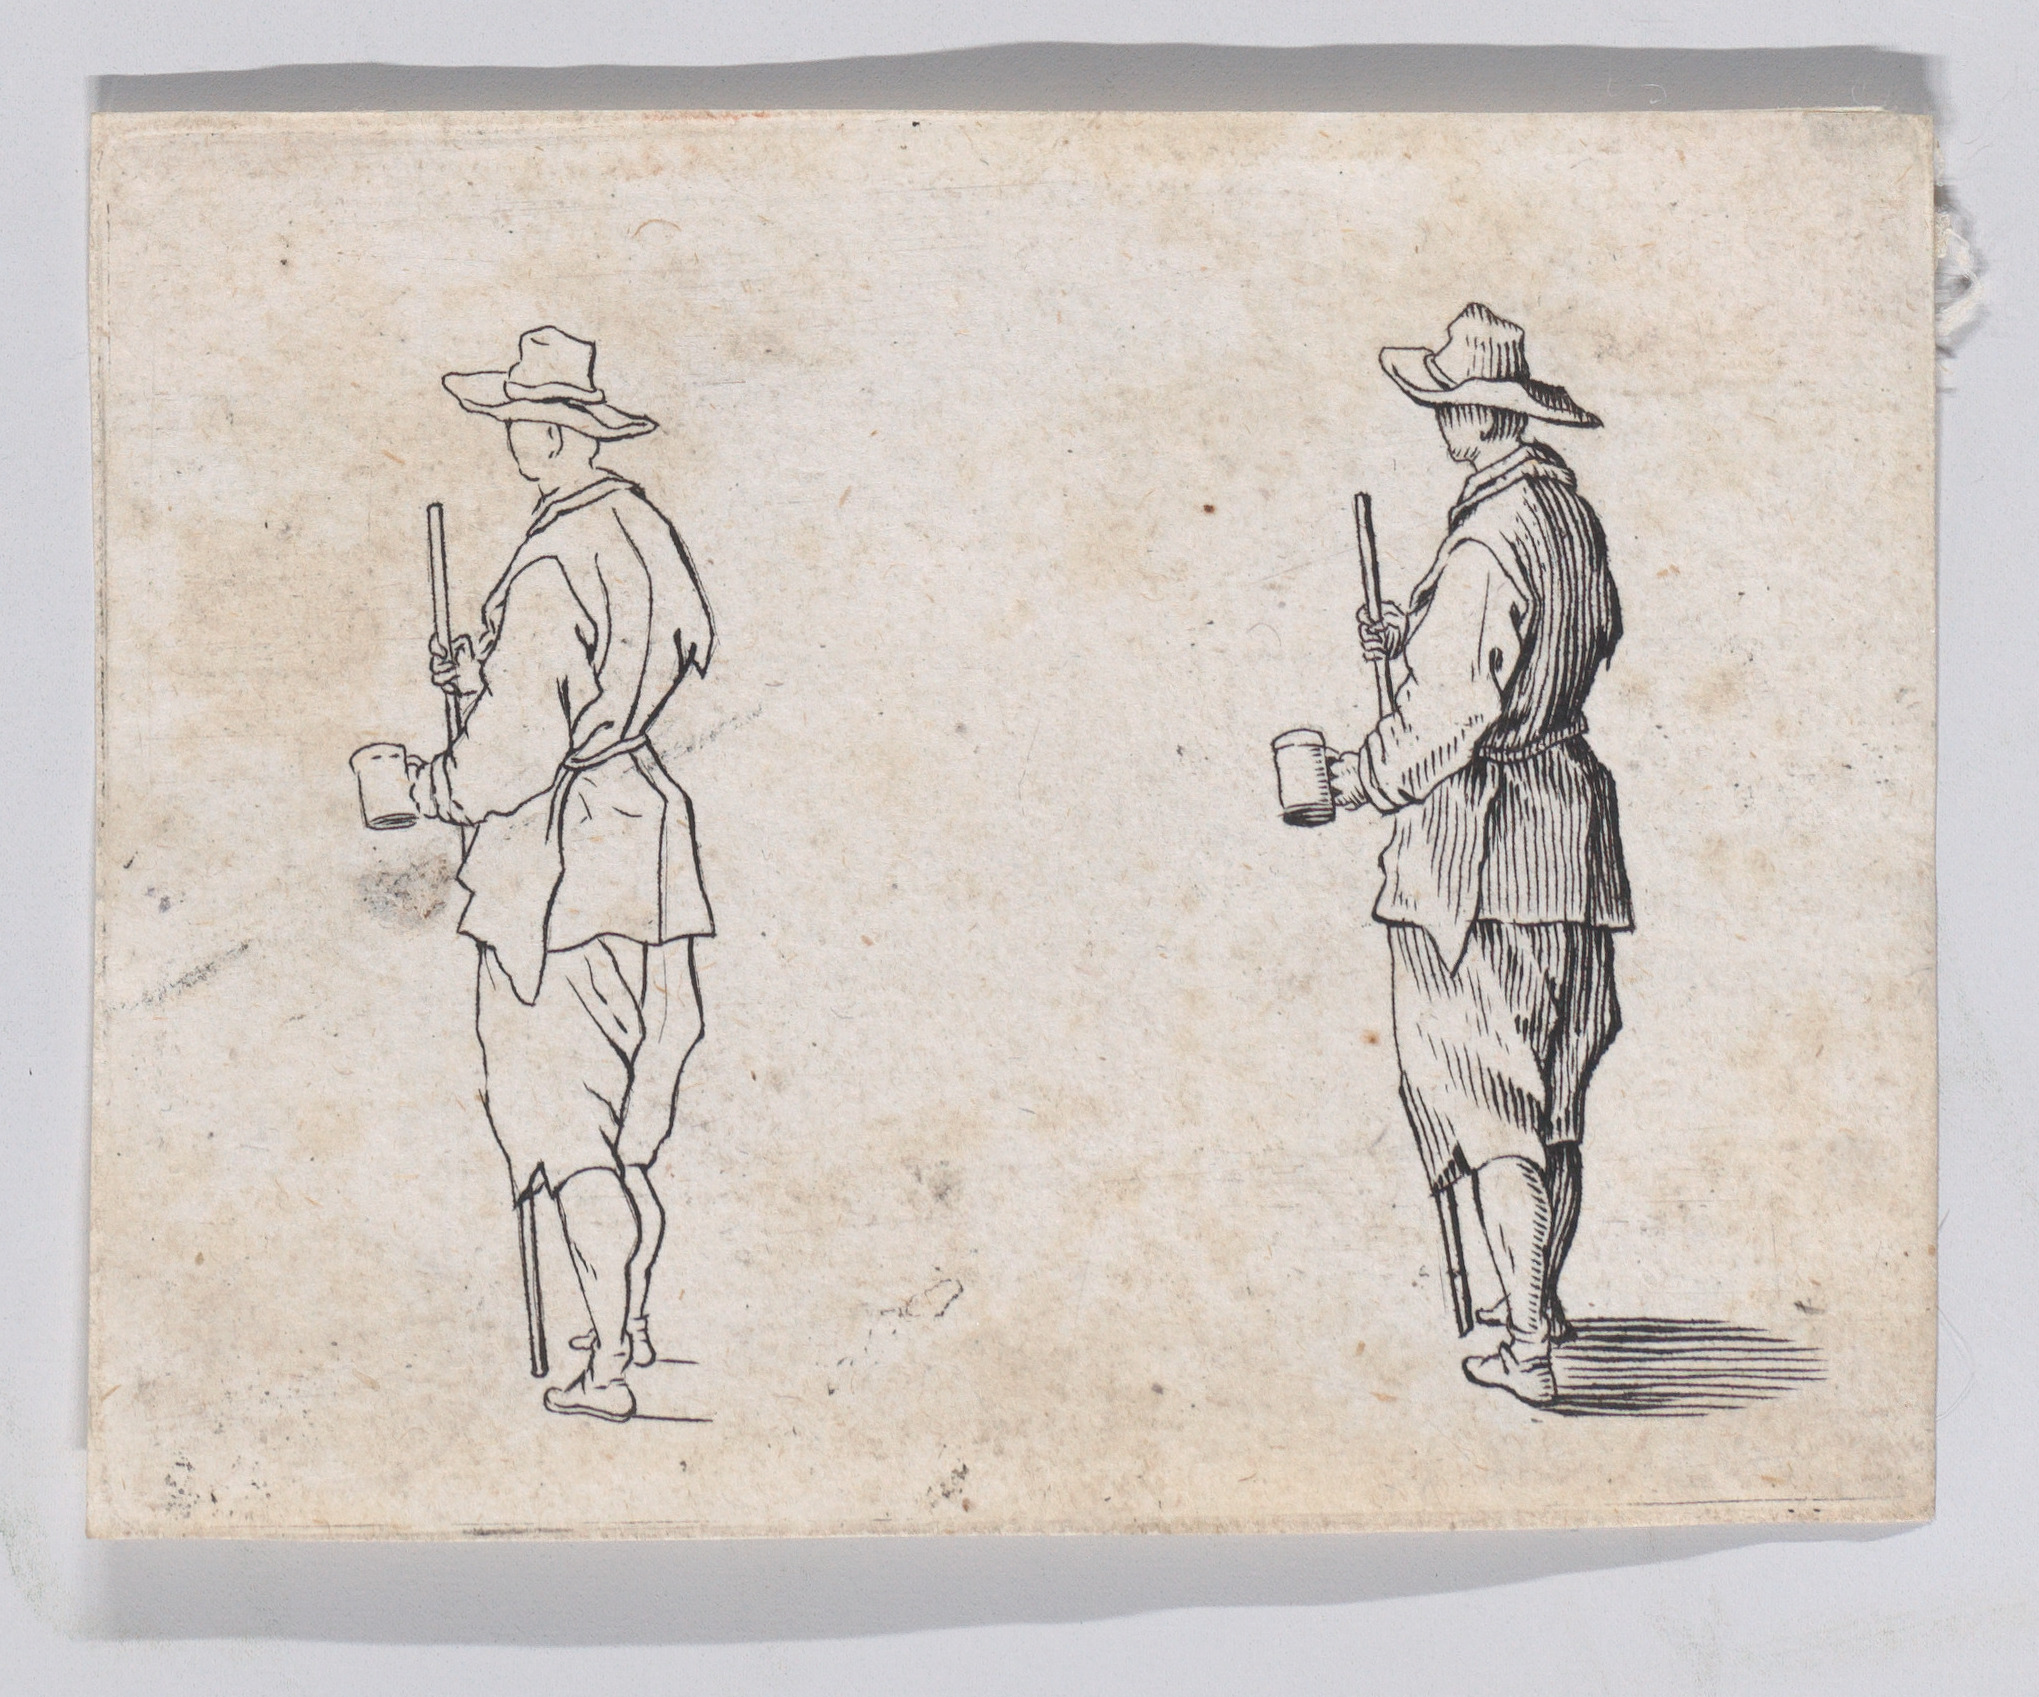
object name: print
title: Reverse Copy of Le Paysan Tenant un Gobelet (The Peasant Holding a Cup), from "Les Caprices" Series A, The Florence Set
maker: Anonymous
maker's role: artist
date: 1601-1700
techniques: etching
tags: men